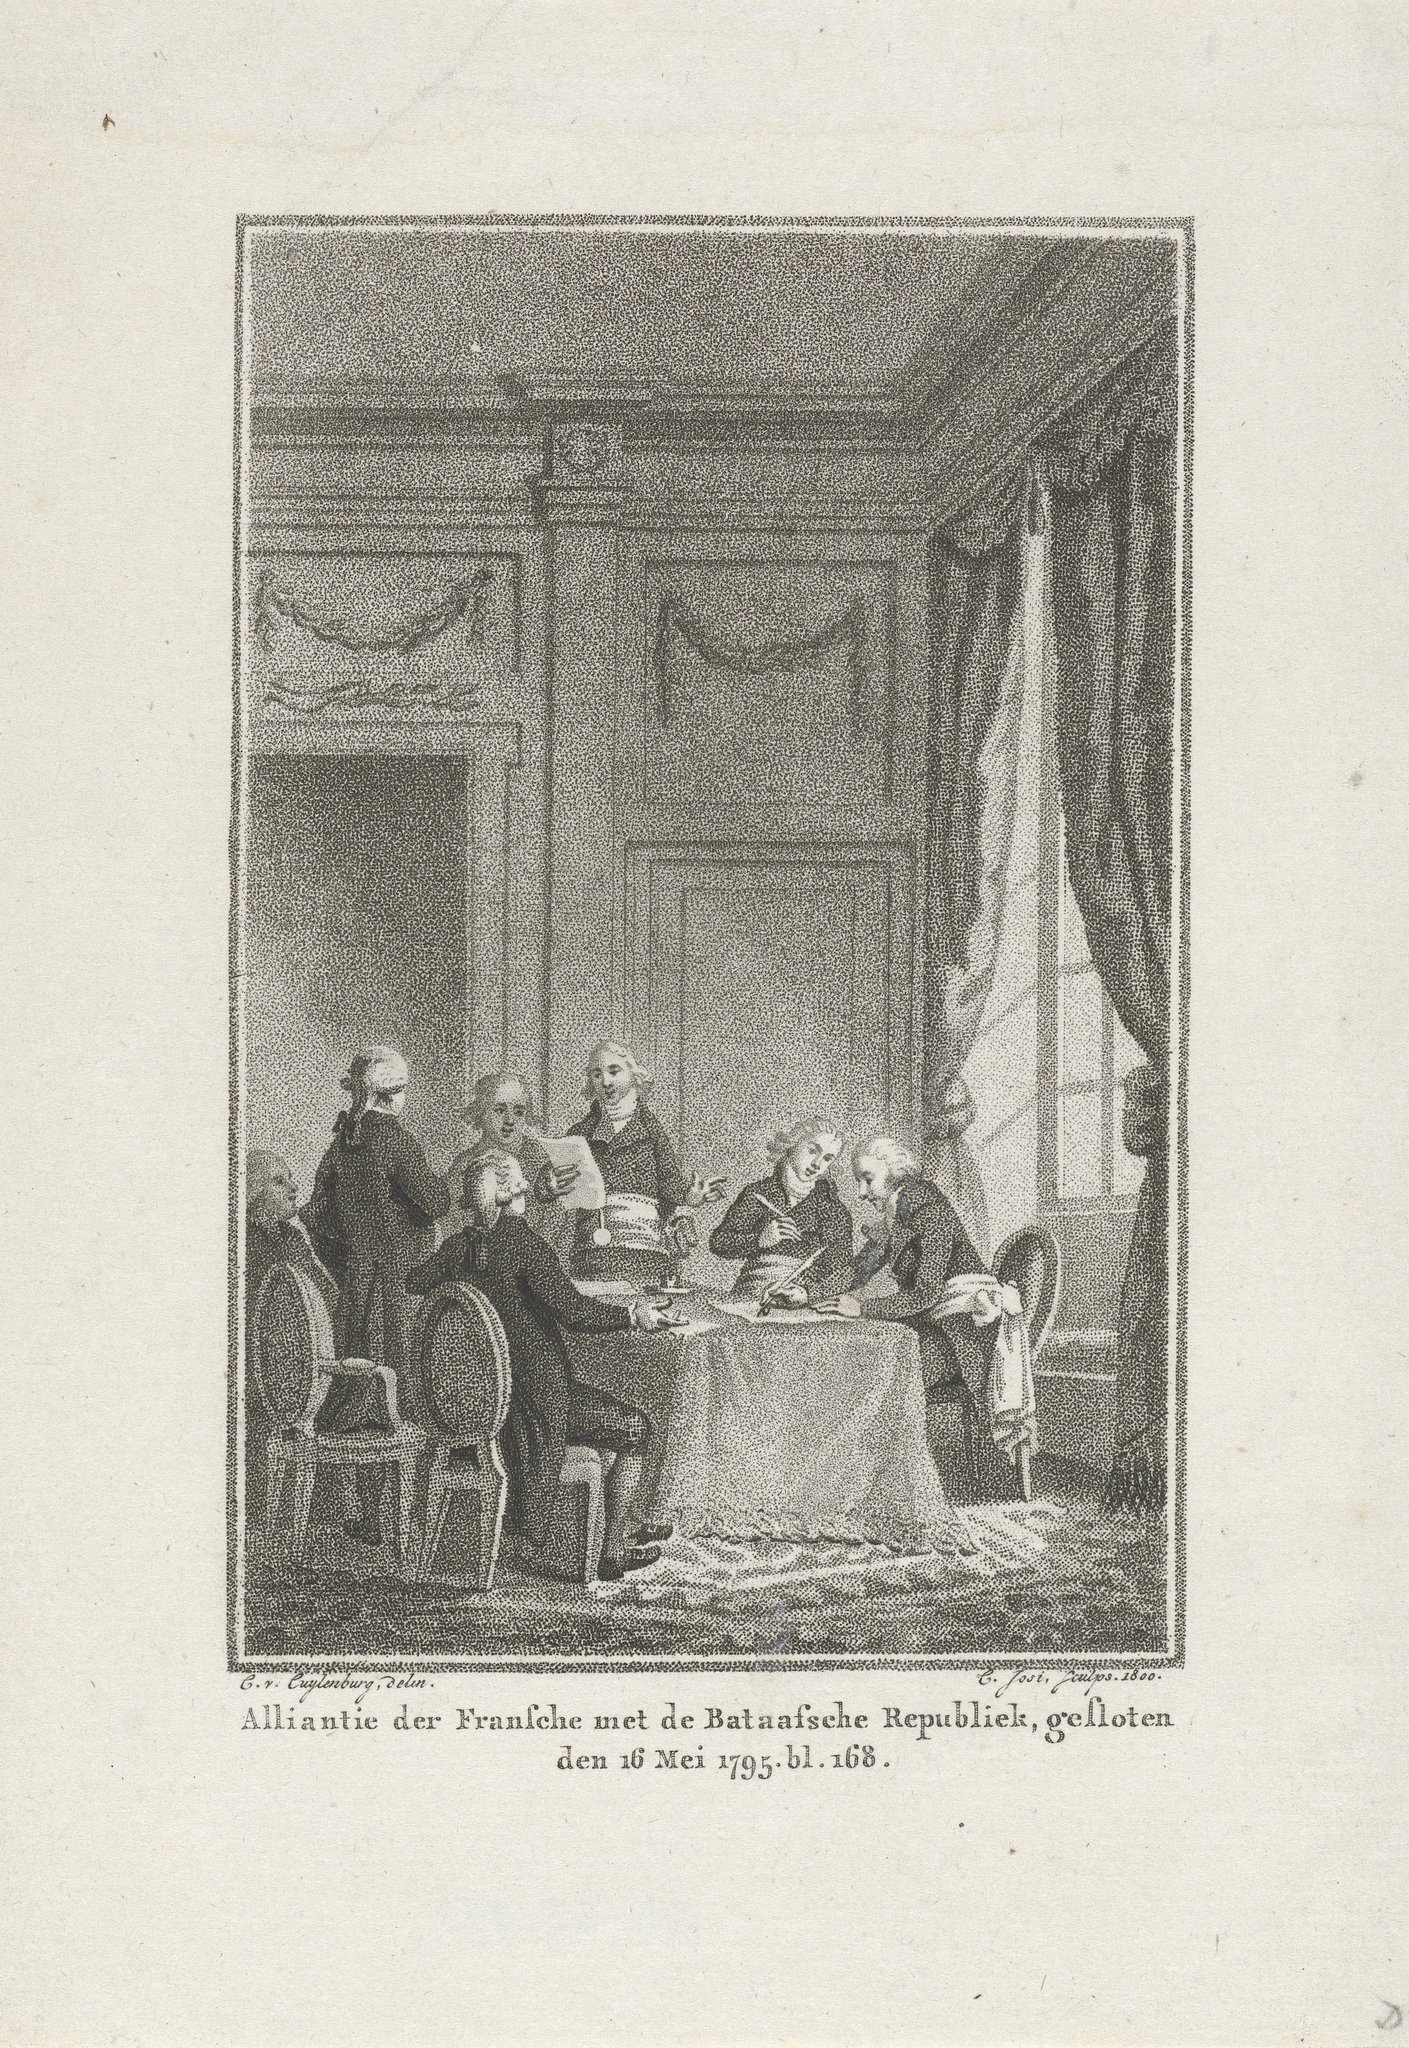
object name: print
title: Sluiten van alliantie tussen Frankrijk en de Bataafse Republiek, 1795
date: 1800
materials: paper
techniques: engraving, etching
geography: amsterdam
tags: alliance with france (1795)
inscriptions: collector's mark: Lugt 2228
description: Interieur met diverse figuren aan en rondom een tafel. Enkele van hen schrijven, één van hen staat en leest voor van een vel papier. Ze sluiten een alliantie tussen Frankrijk en de Bataafse Republiek, op 16 mei 1795.